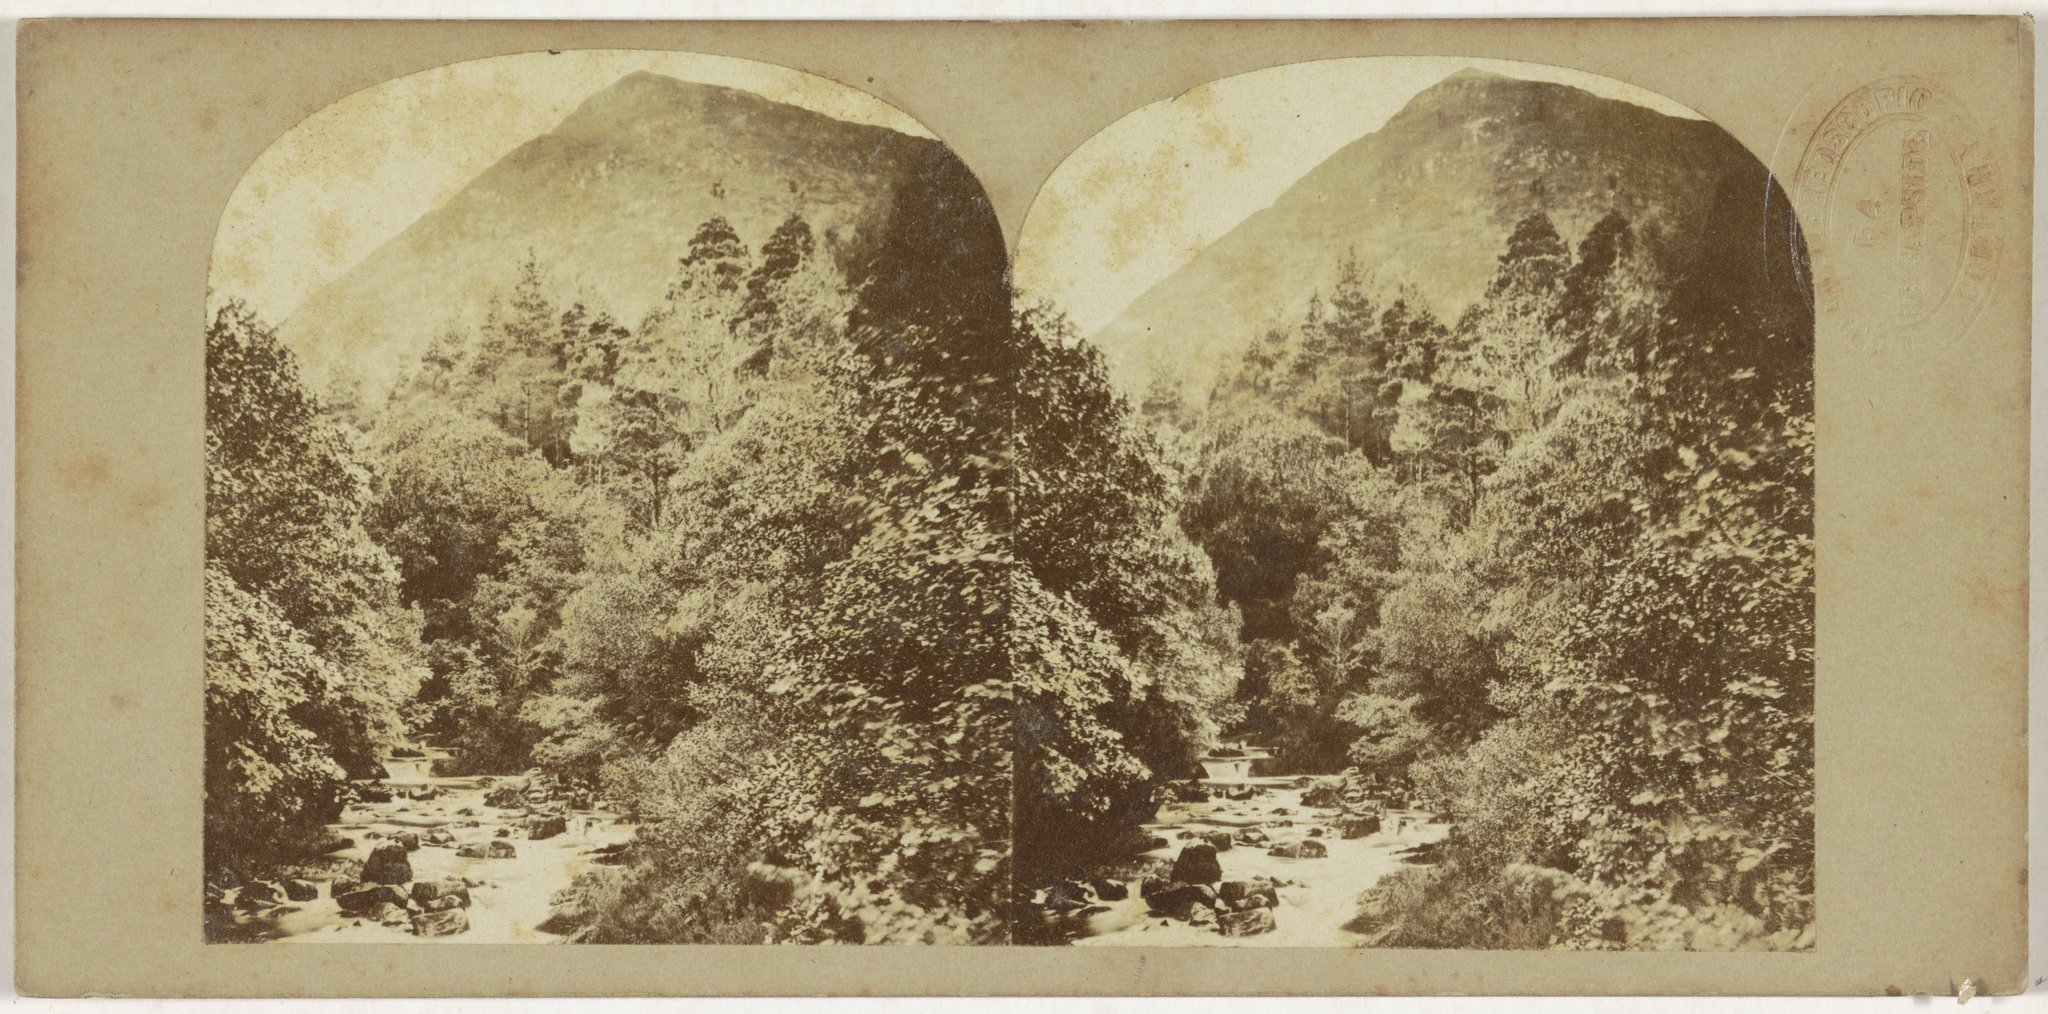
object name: stereograph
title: Gezicht op rivier nabij de Old Mountain Road, Killarney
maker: Anonymous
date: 1856-1922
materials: cardboard, paper, photographic support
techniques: albumen print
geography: london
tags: killarney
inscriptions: name: ‘H. Ameschot.’, label: ‘View near the Old Mountain Road, Killarney.’, check stamp: ‘London Stereoscopic Company / 54 Cheapside’, inscription: ‘N.° 10.’